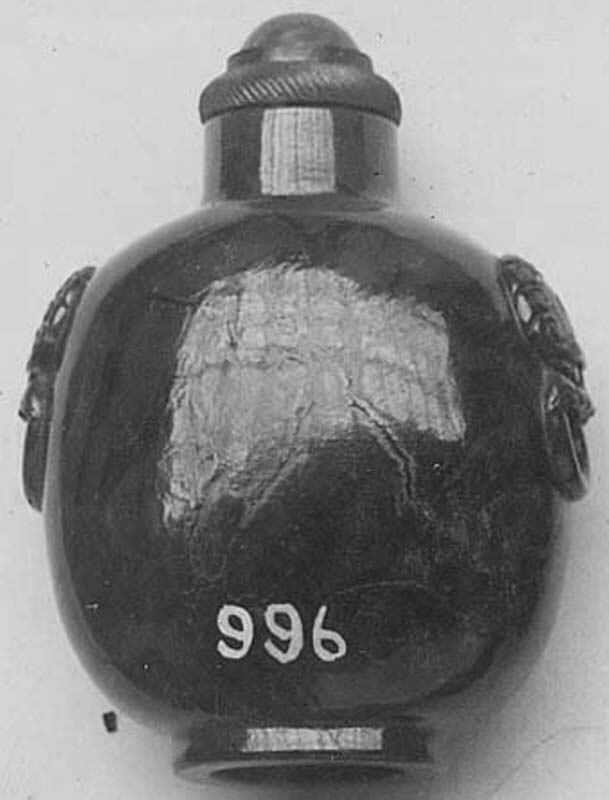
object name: snuff bottle with stopper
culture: chinese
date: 1701-1900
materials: jasper